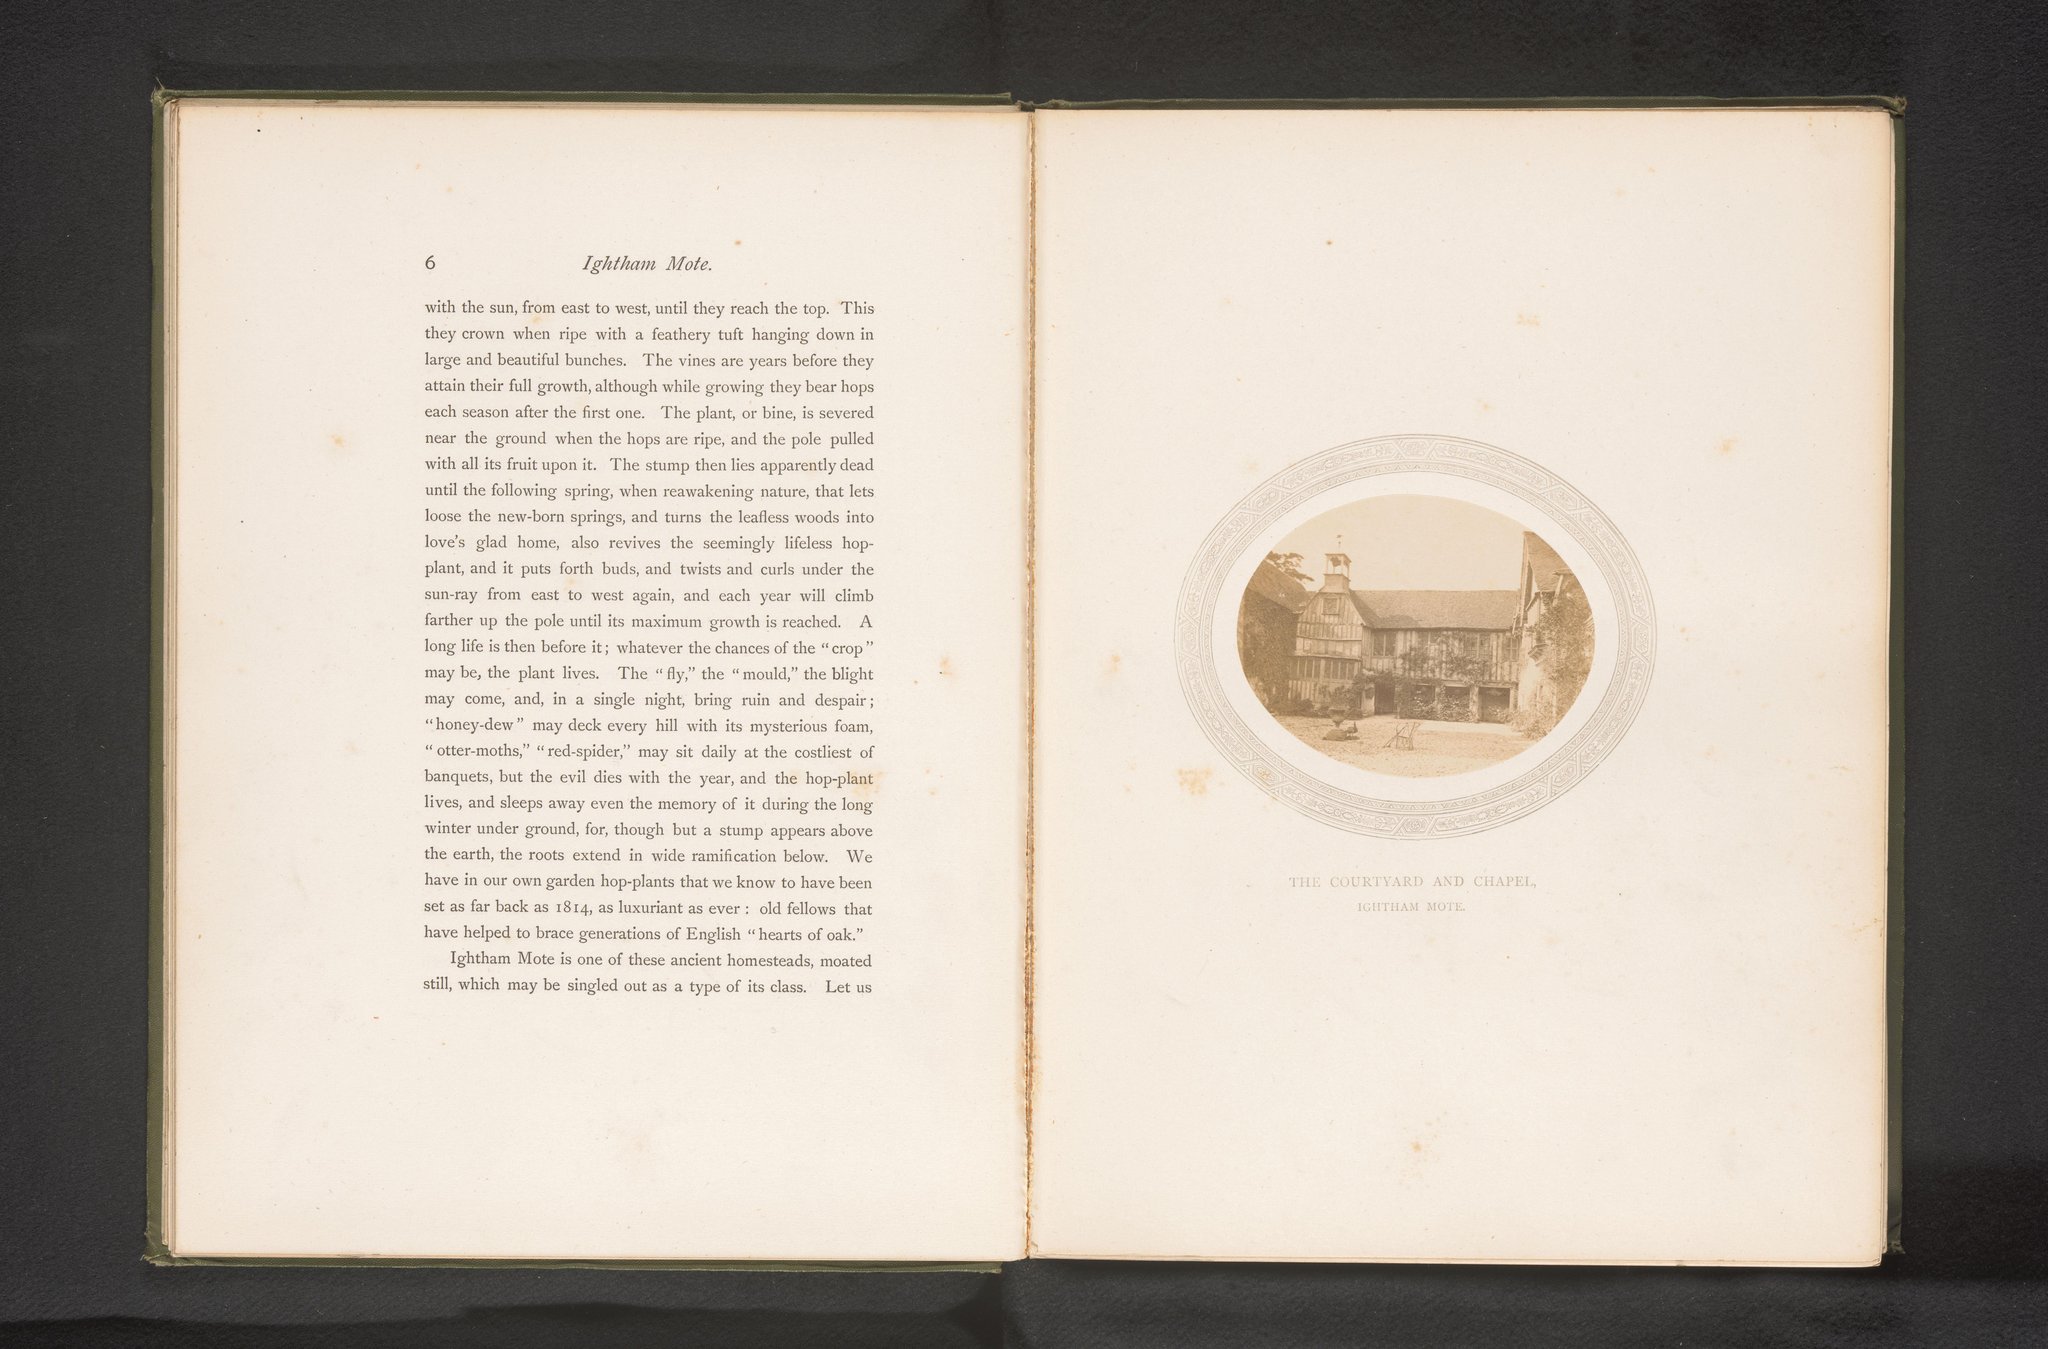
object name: page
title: The courtyard and chapel, Ightham Mote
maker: stephen thompson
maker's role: fotograaf, schrijver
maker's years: 1831-1893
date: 1866-1876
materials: photographic support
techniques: albumen print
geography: ightham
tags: rural housing, e.g. country-house, villa, cottage, courtyard, church (exterior) - qq - small church, chapel